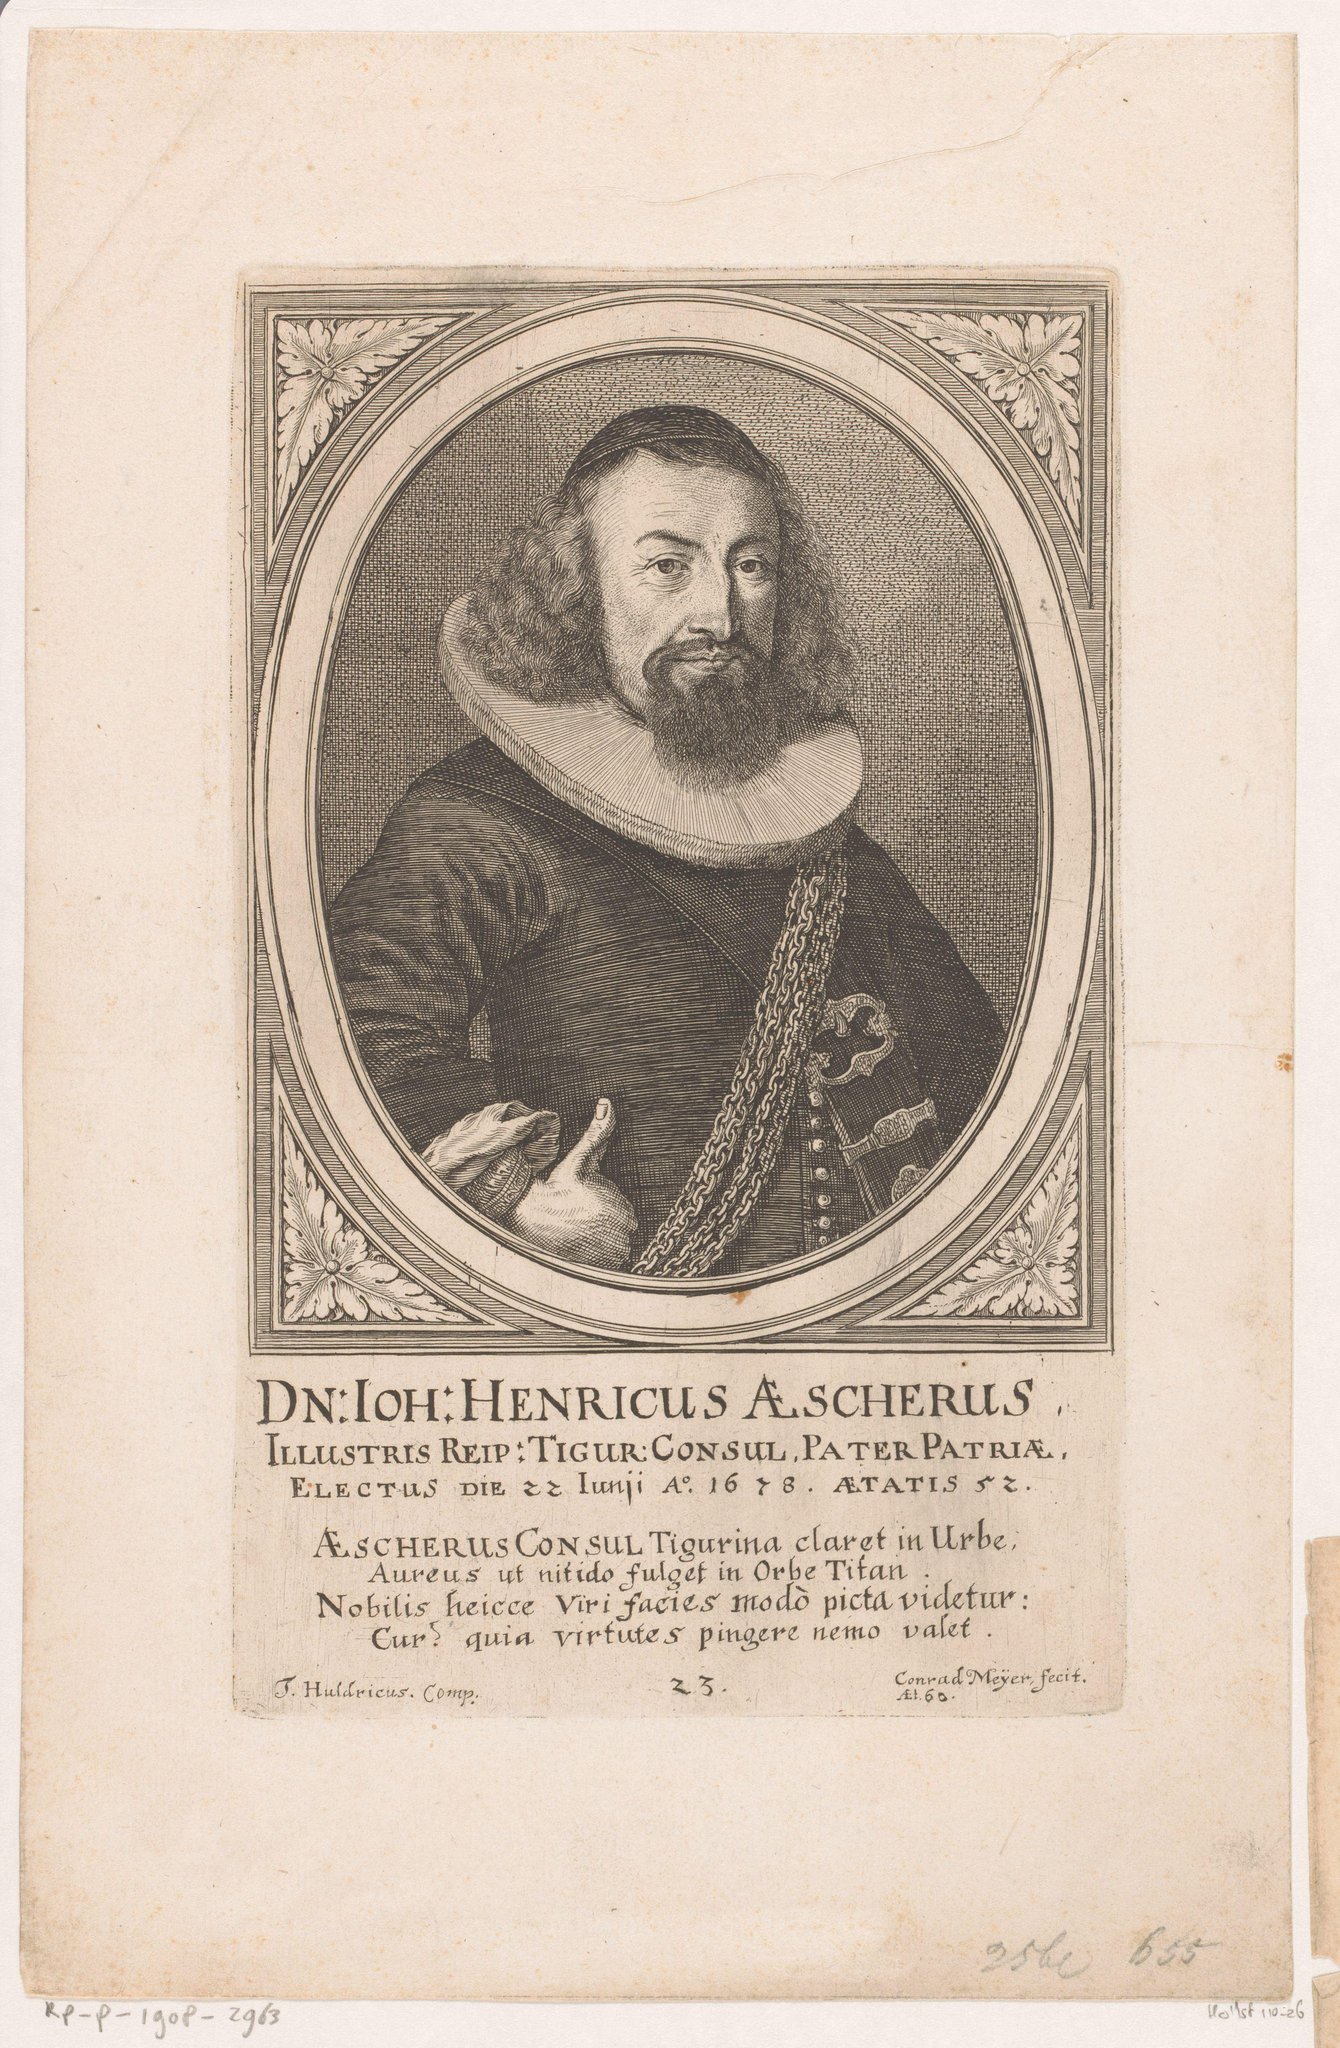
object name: print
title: Portretten van burgemeesters van Zürich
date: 1678-1689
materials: paper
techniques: engraving, etching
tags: mayor, burgomaster, historical persons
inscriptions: collector's mark: Lugt 2228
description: Onderdeel van een serie van 67(?) portretten van burgemeesters van Zürich. Zie Hollstein German 110, 1-26.